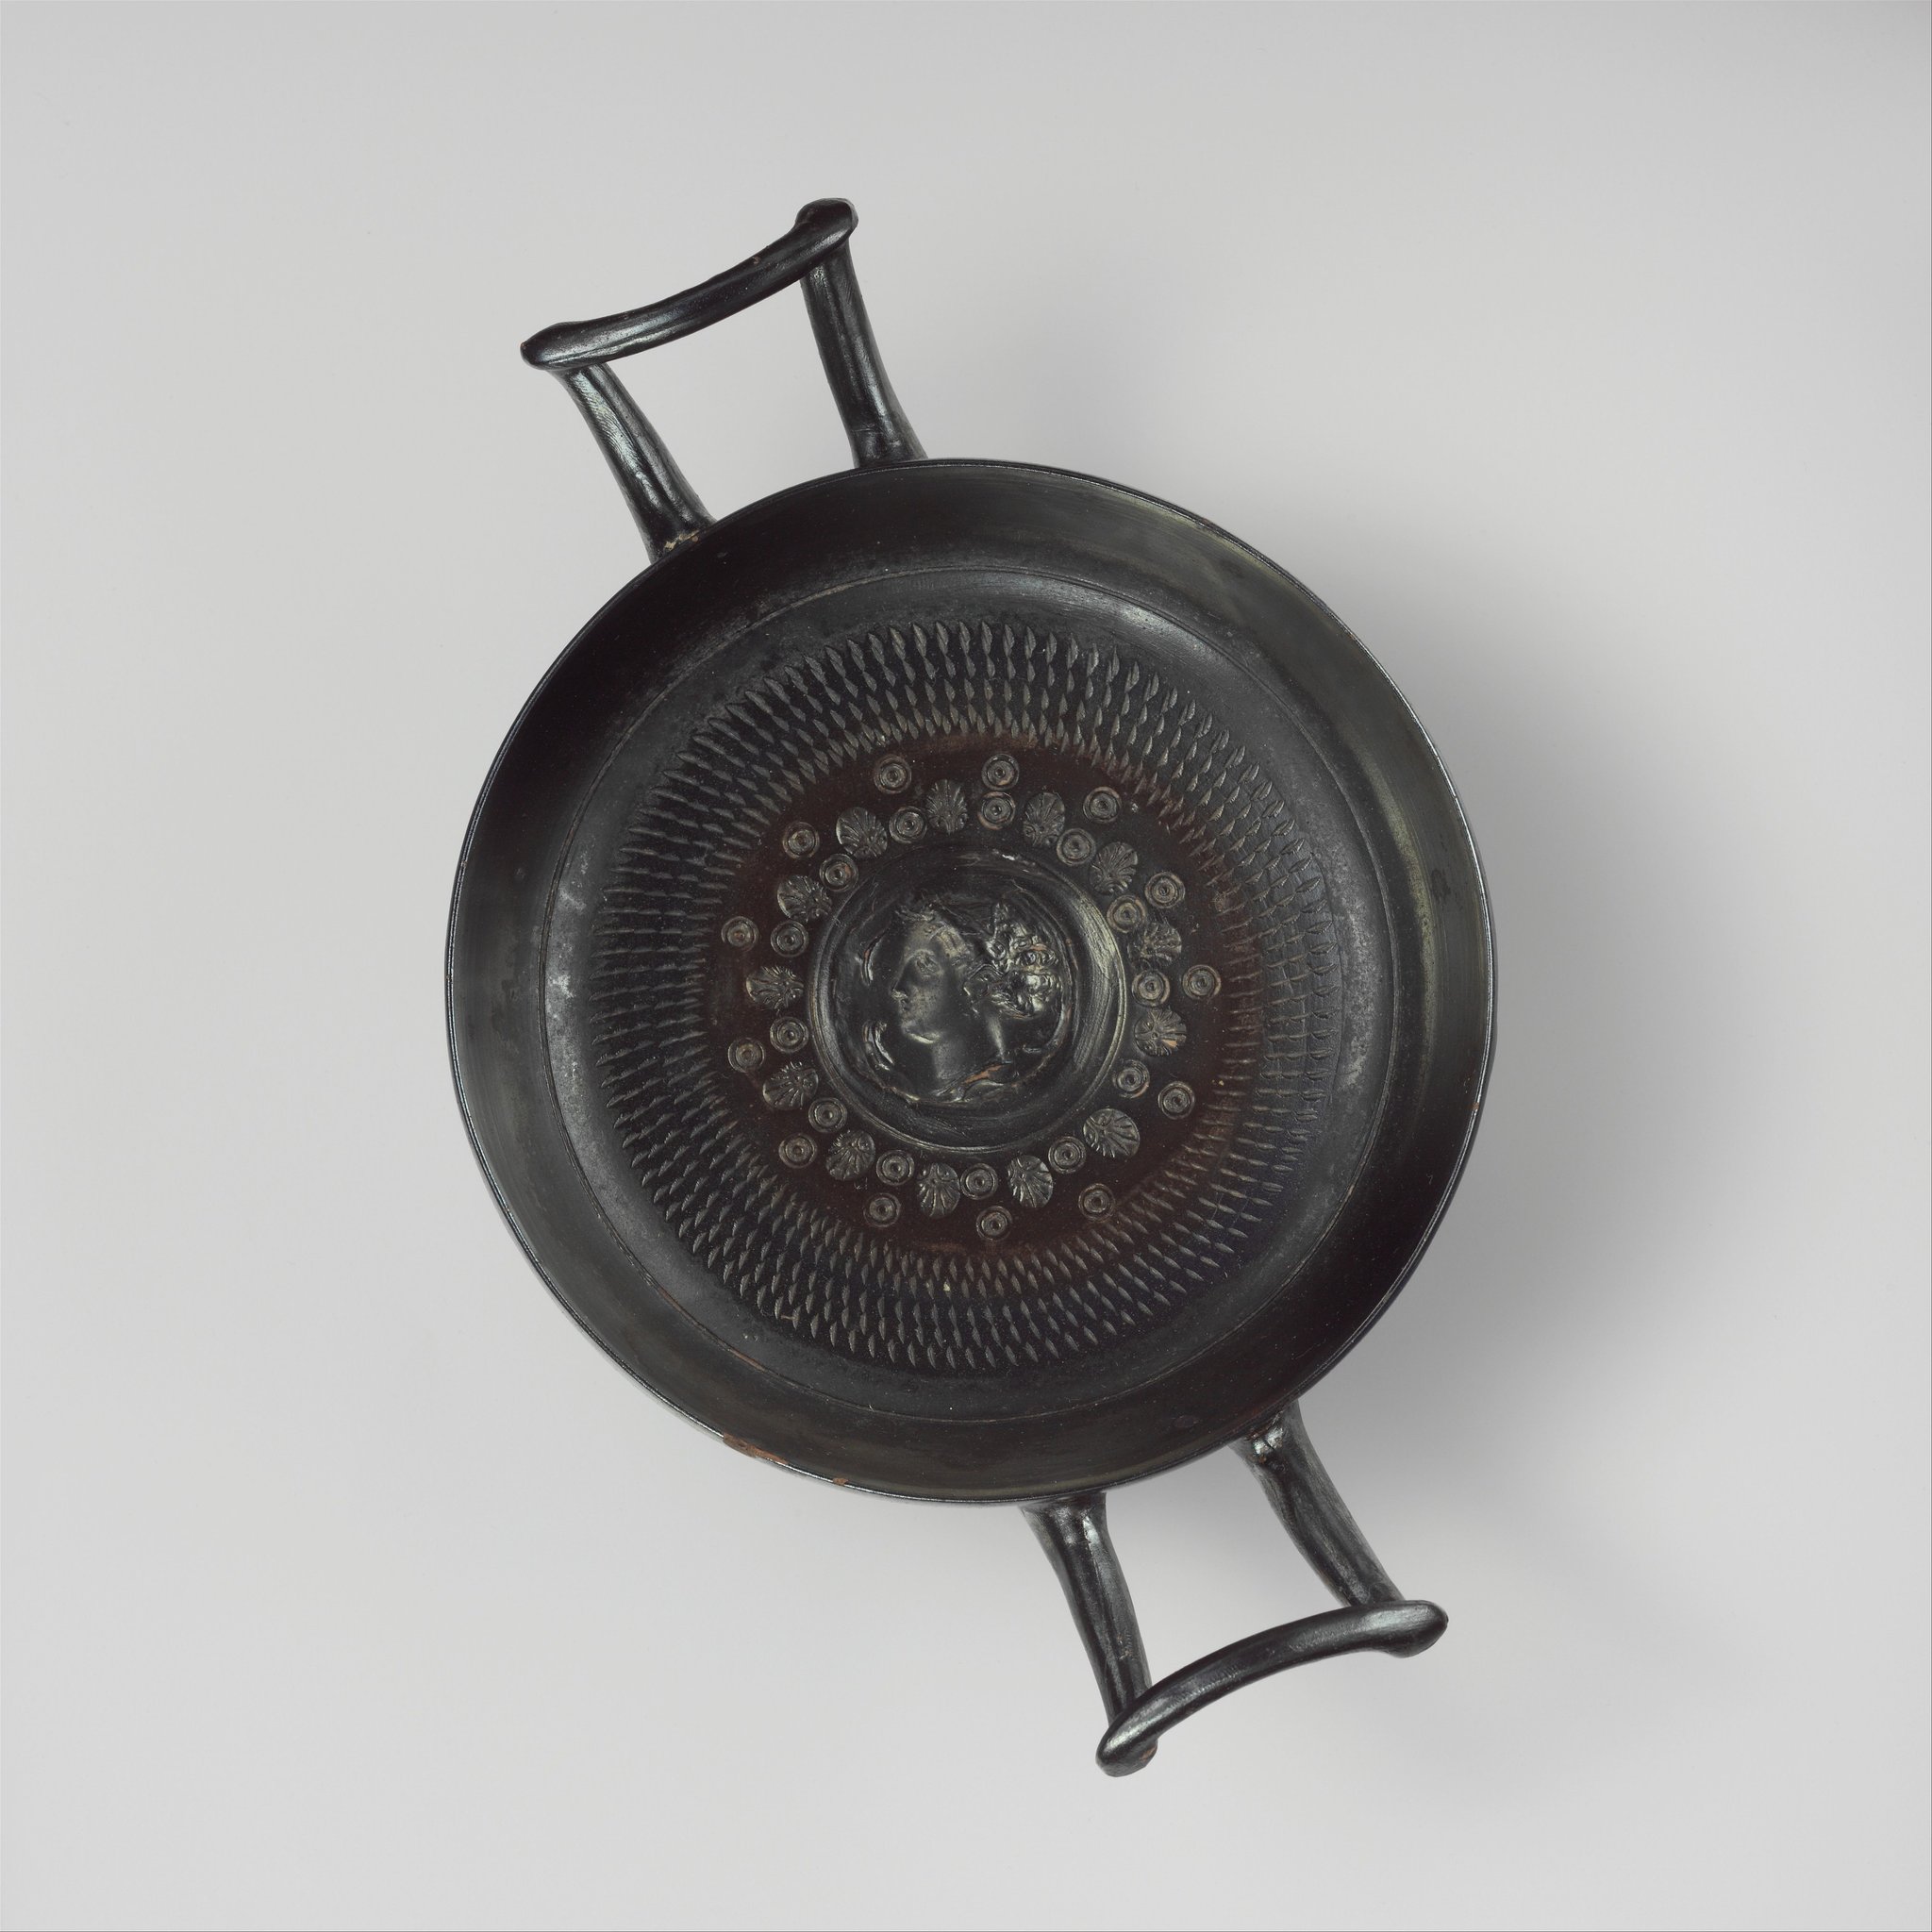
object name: kylix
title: Terracotta stemless kylix (drinking cup)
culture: greek, calenian or campanian or south italian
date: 334-201 BCE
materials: terracotta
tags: women